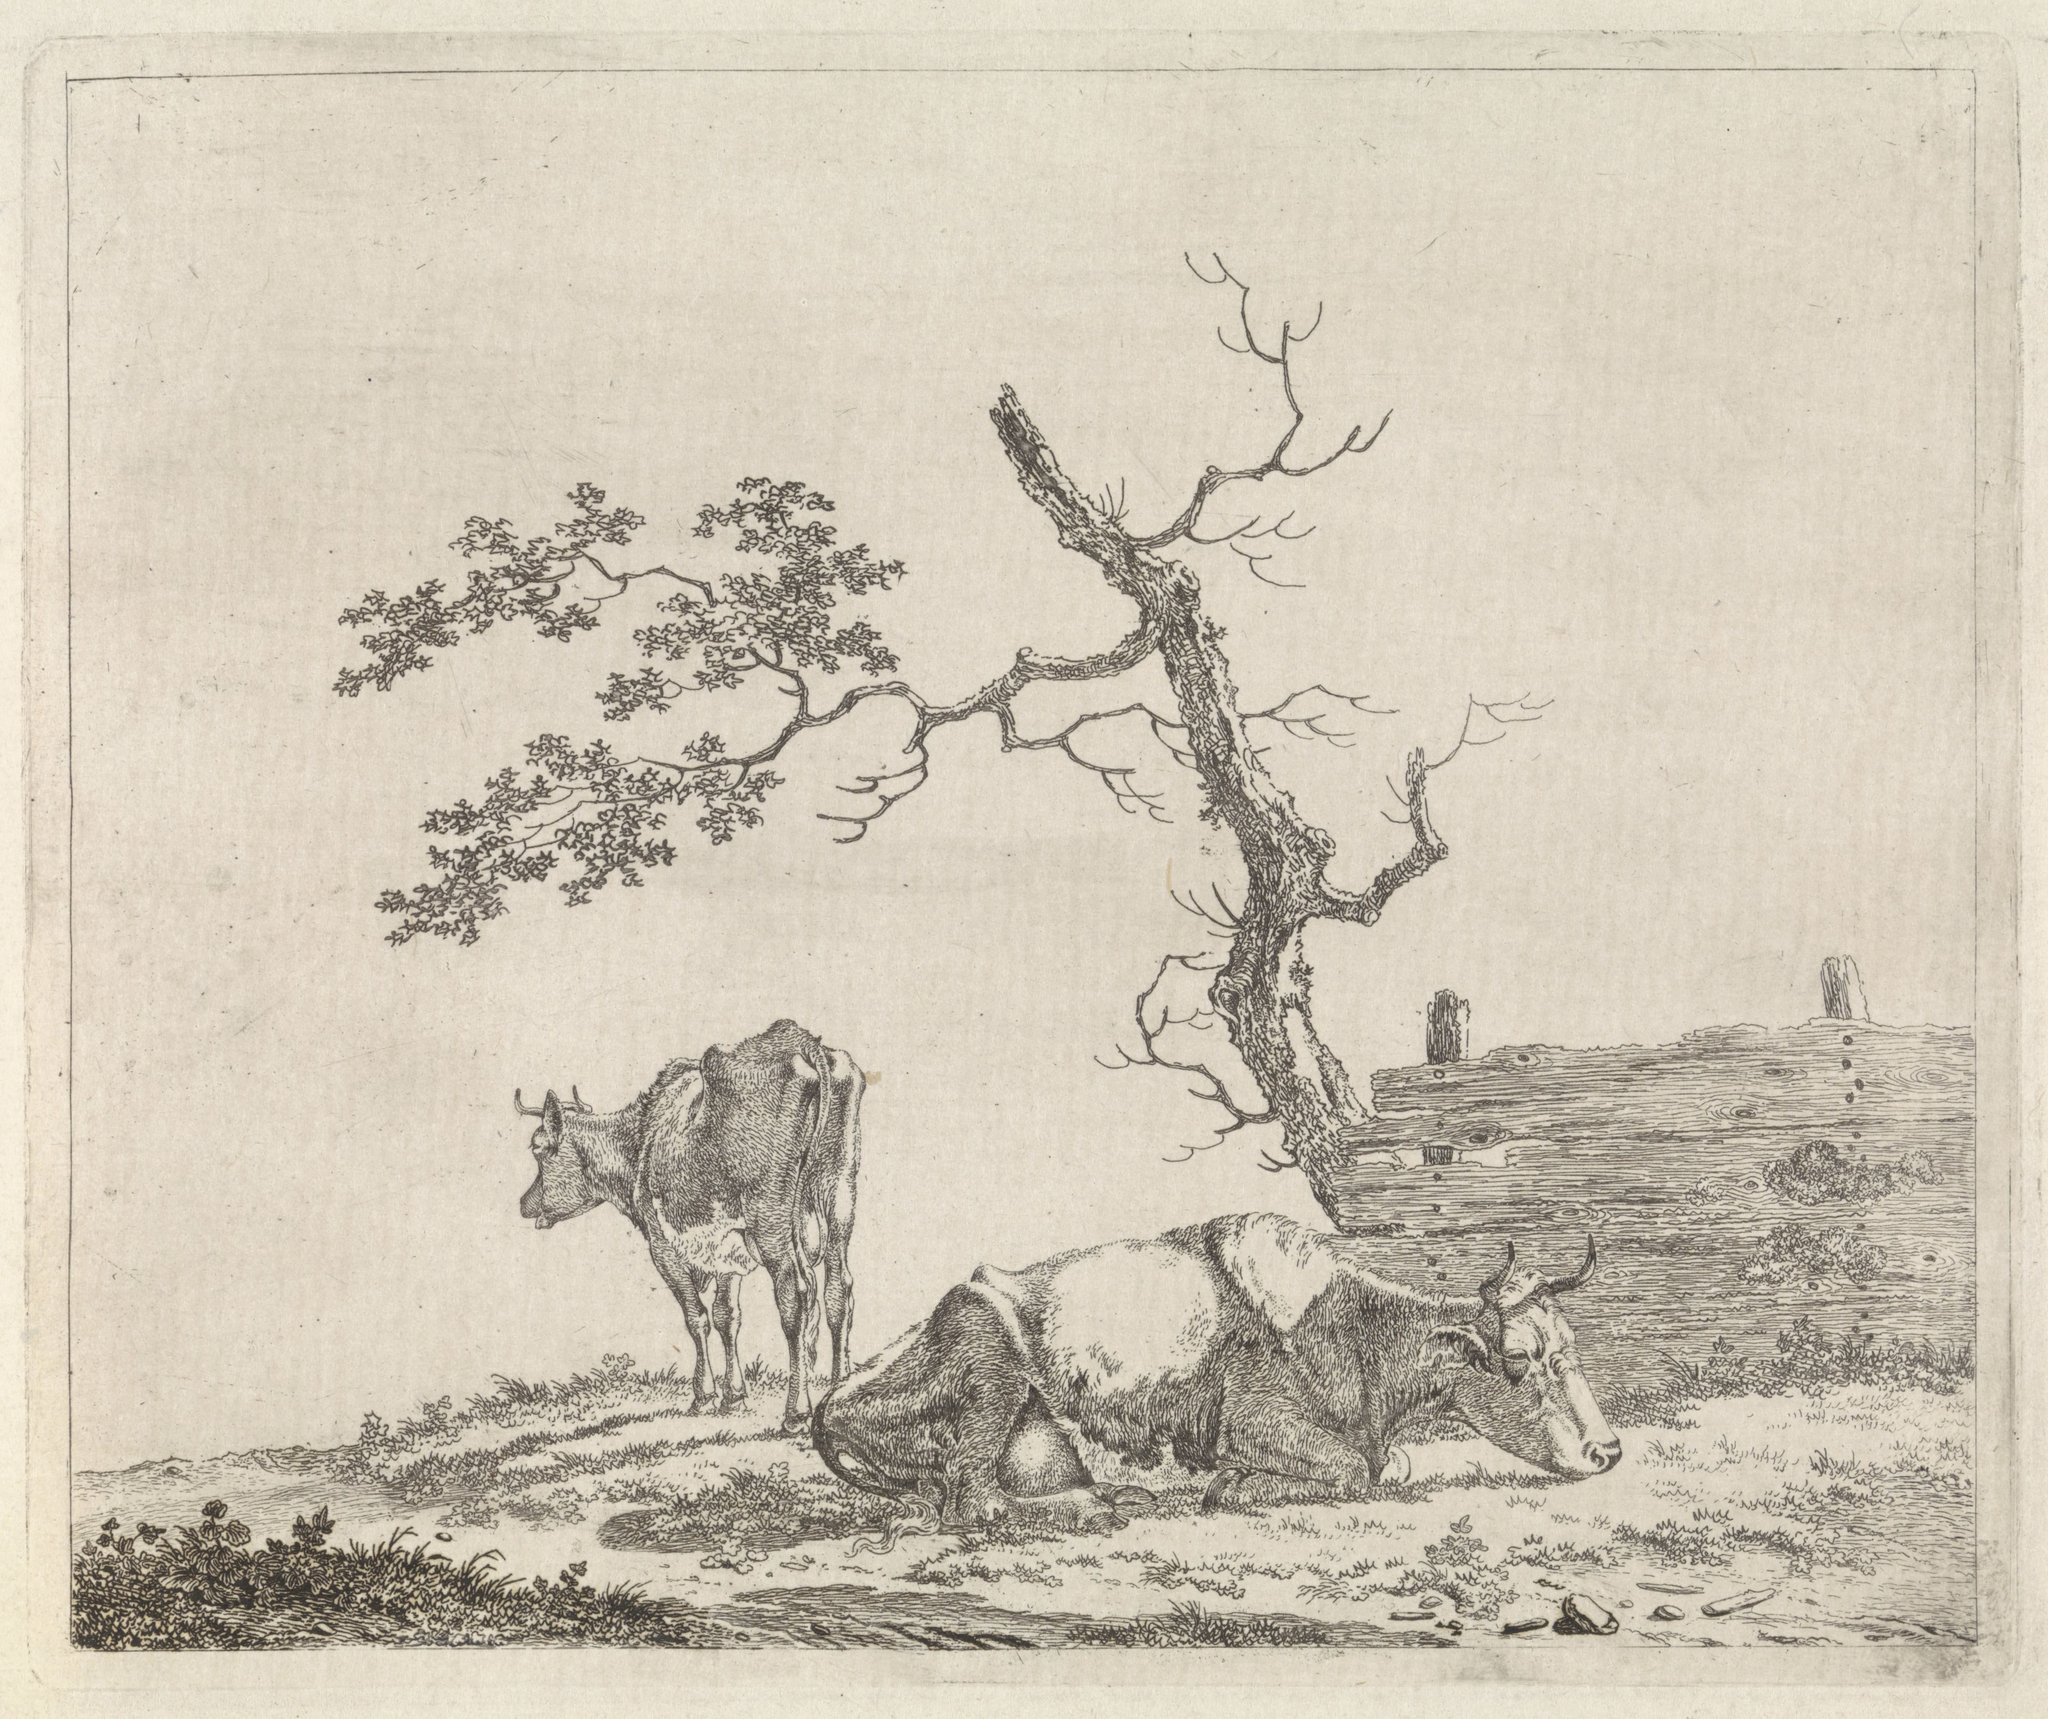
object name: print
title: Twee koeien bij hek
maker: pieter janson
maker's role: draughtsman, print maker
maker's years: 1765-1851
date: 1780-1851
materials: paper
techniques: etching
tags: cow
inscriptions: collector's mark: Lugt 240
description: Landschap met twee koeien bij een hek met daarachter een boom. Eén liggend, de ander staand, van achter gezien. Vóór de lucht.